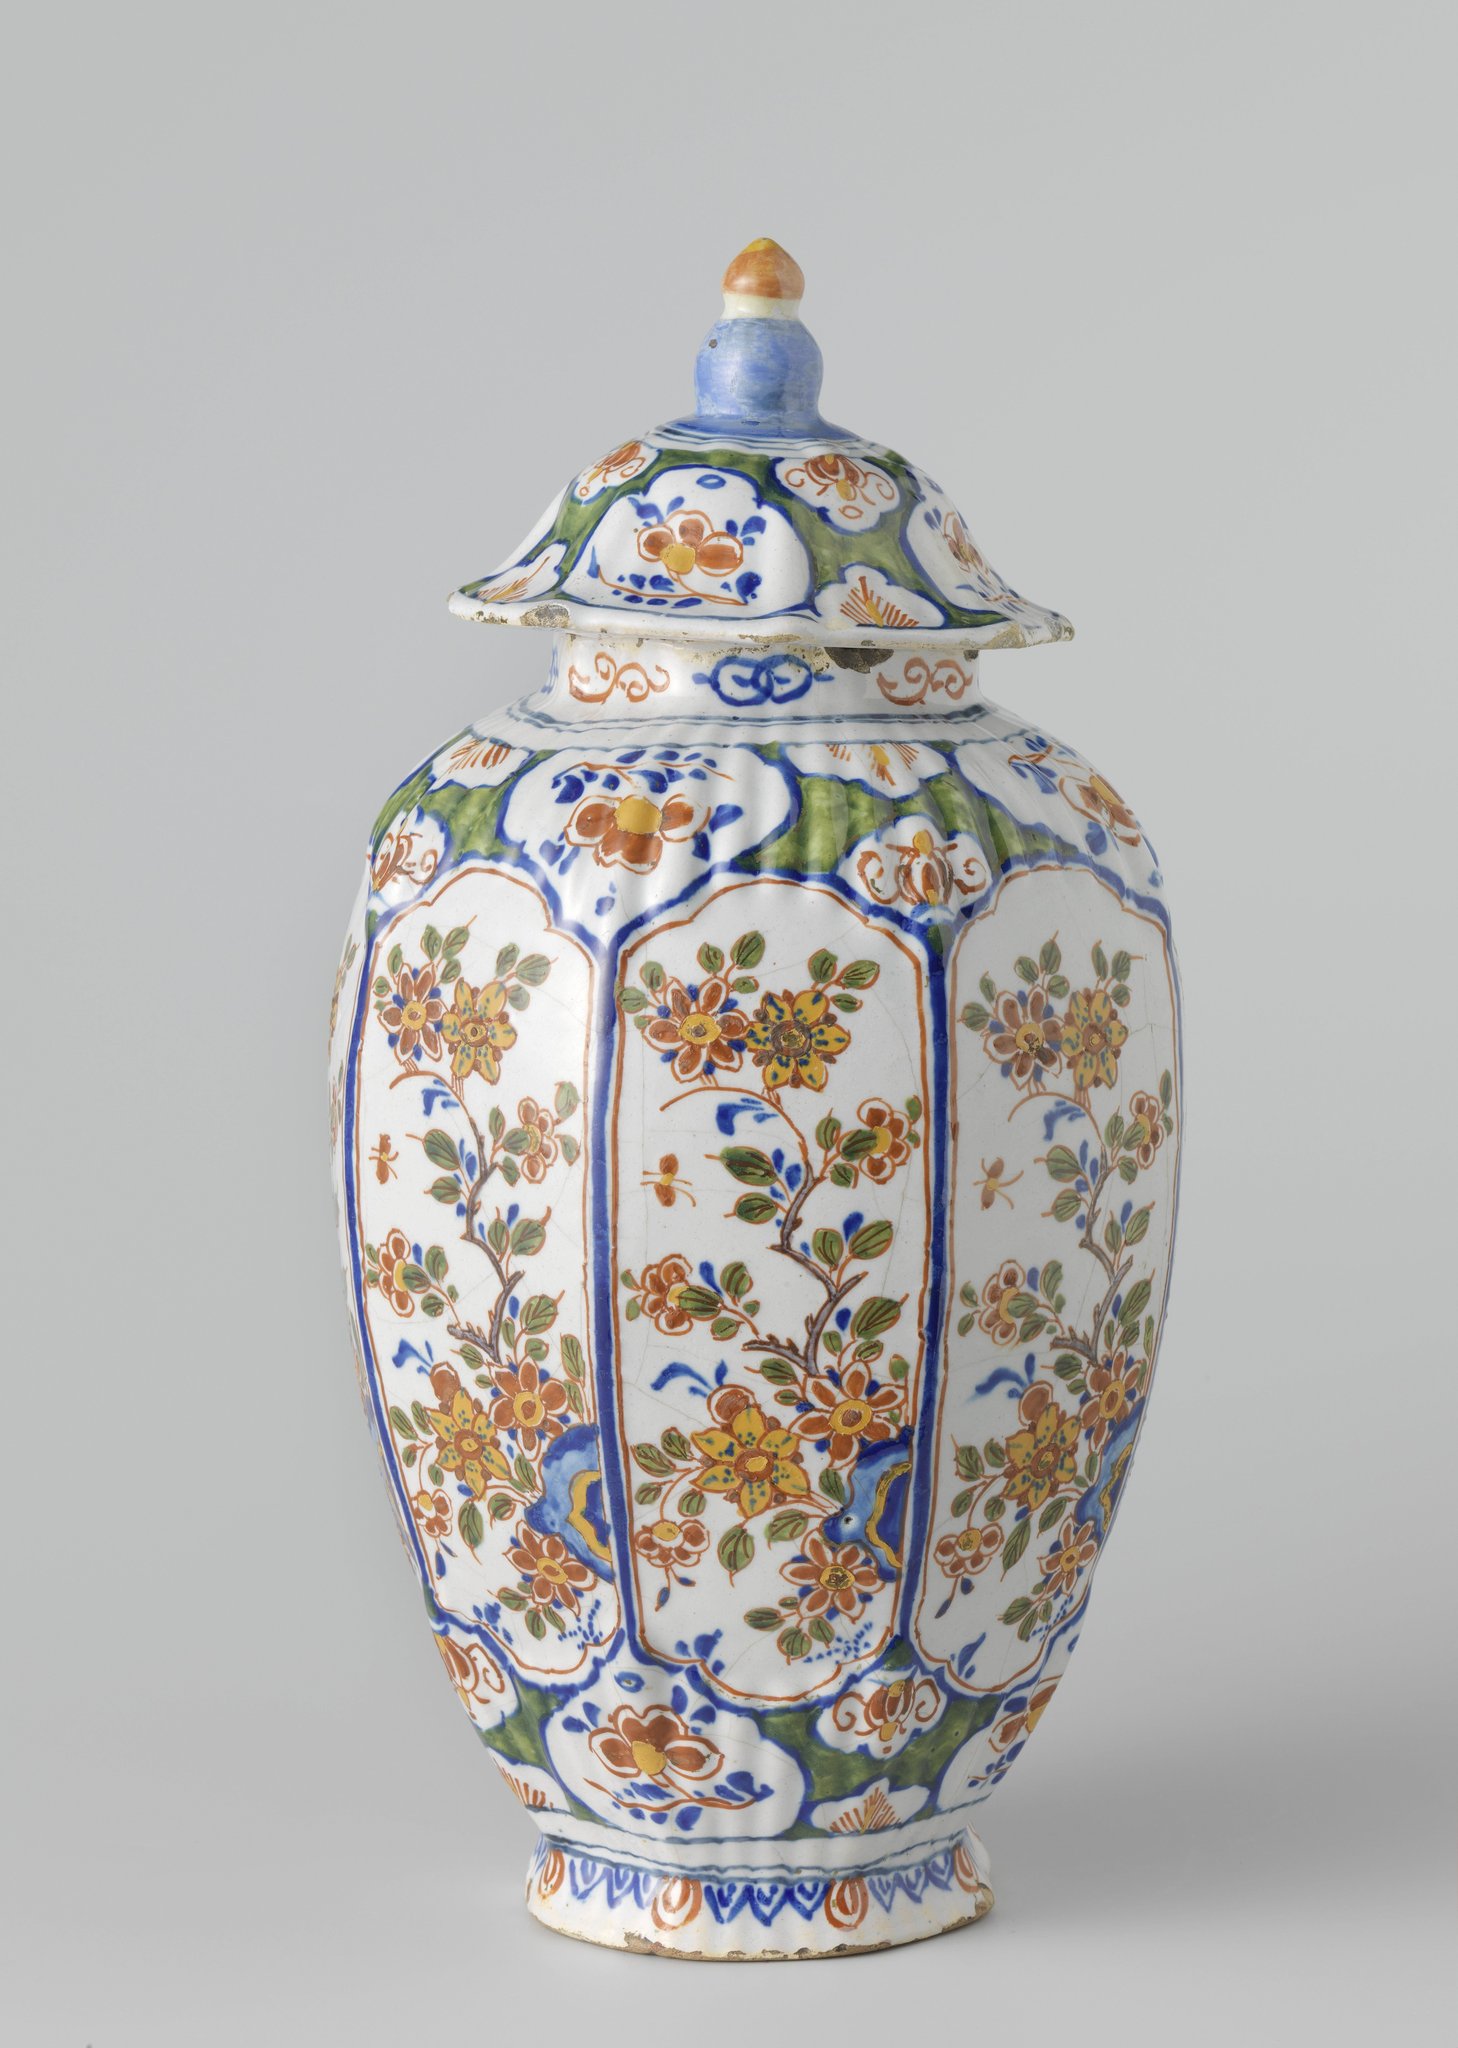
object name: lid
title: Deksel, achthoekig gewelfd, met knop; polychroom versierd met bloemtakken binnen cartouches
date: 1707-1727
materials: earthenware, glaze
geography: delft